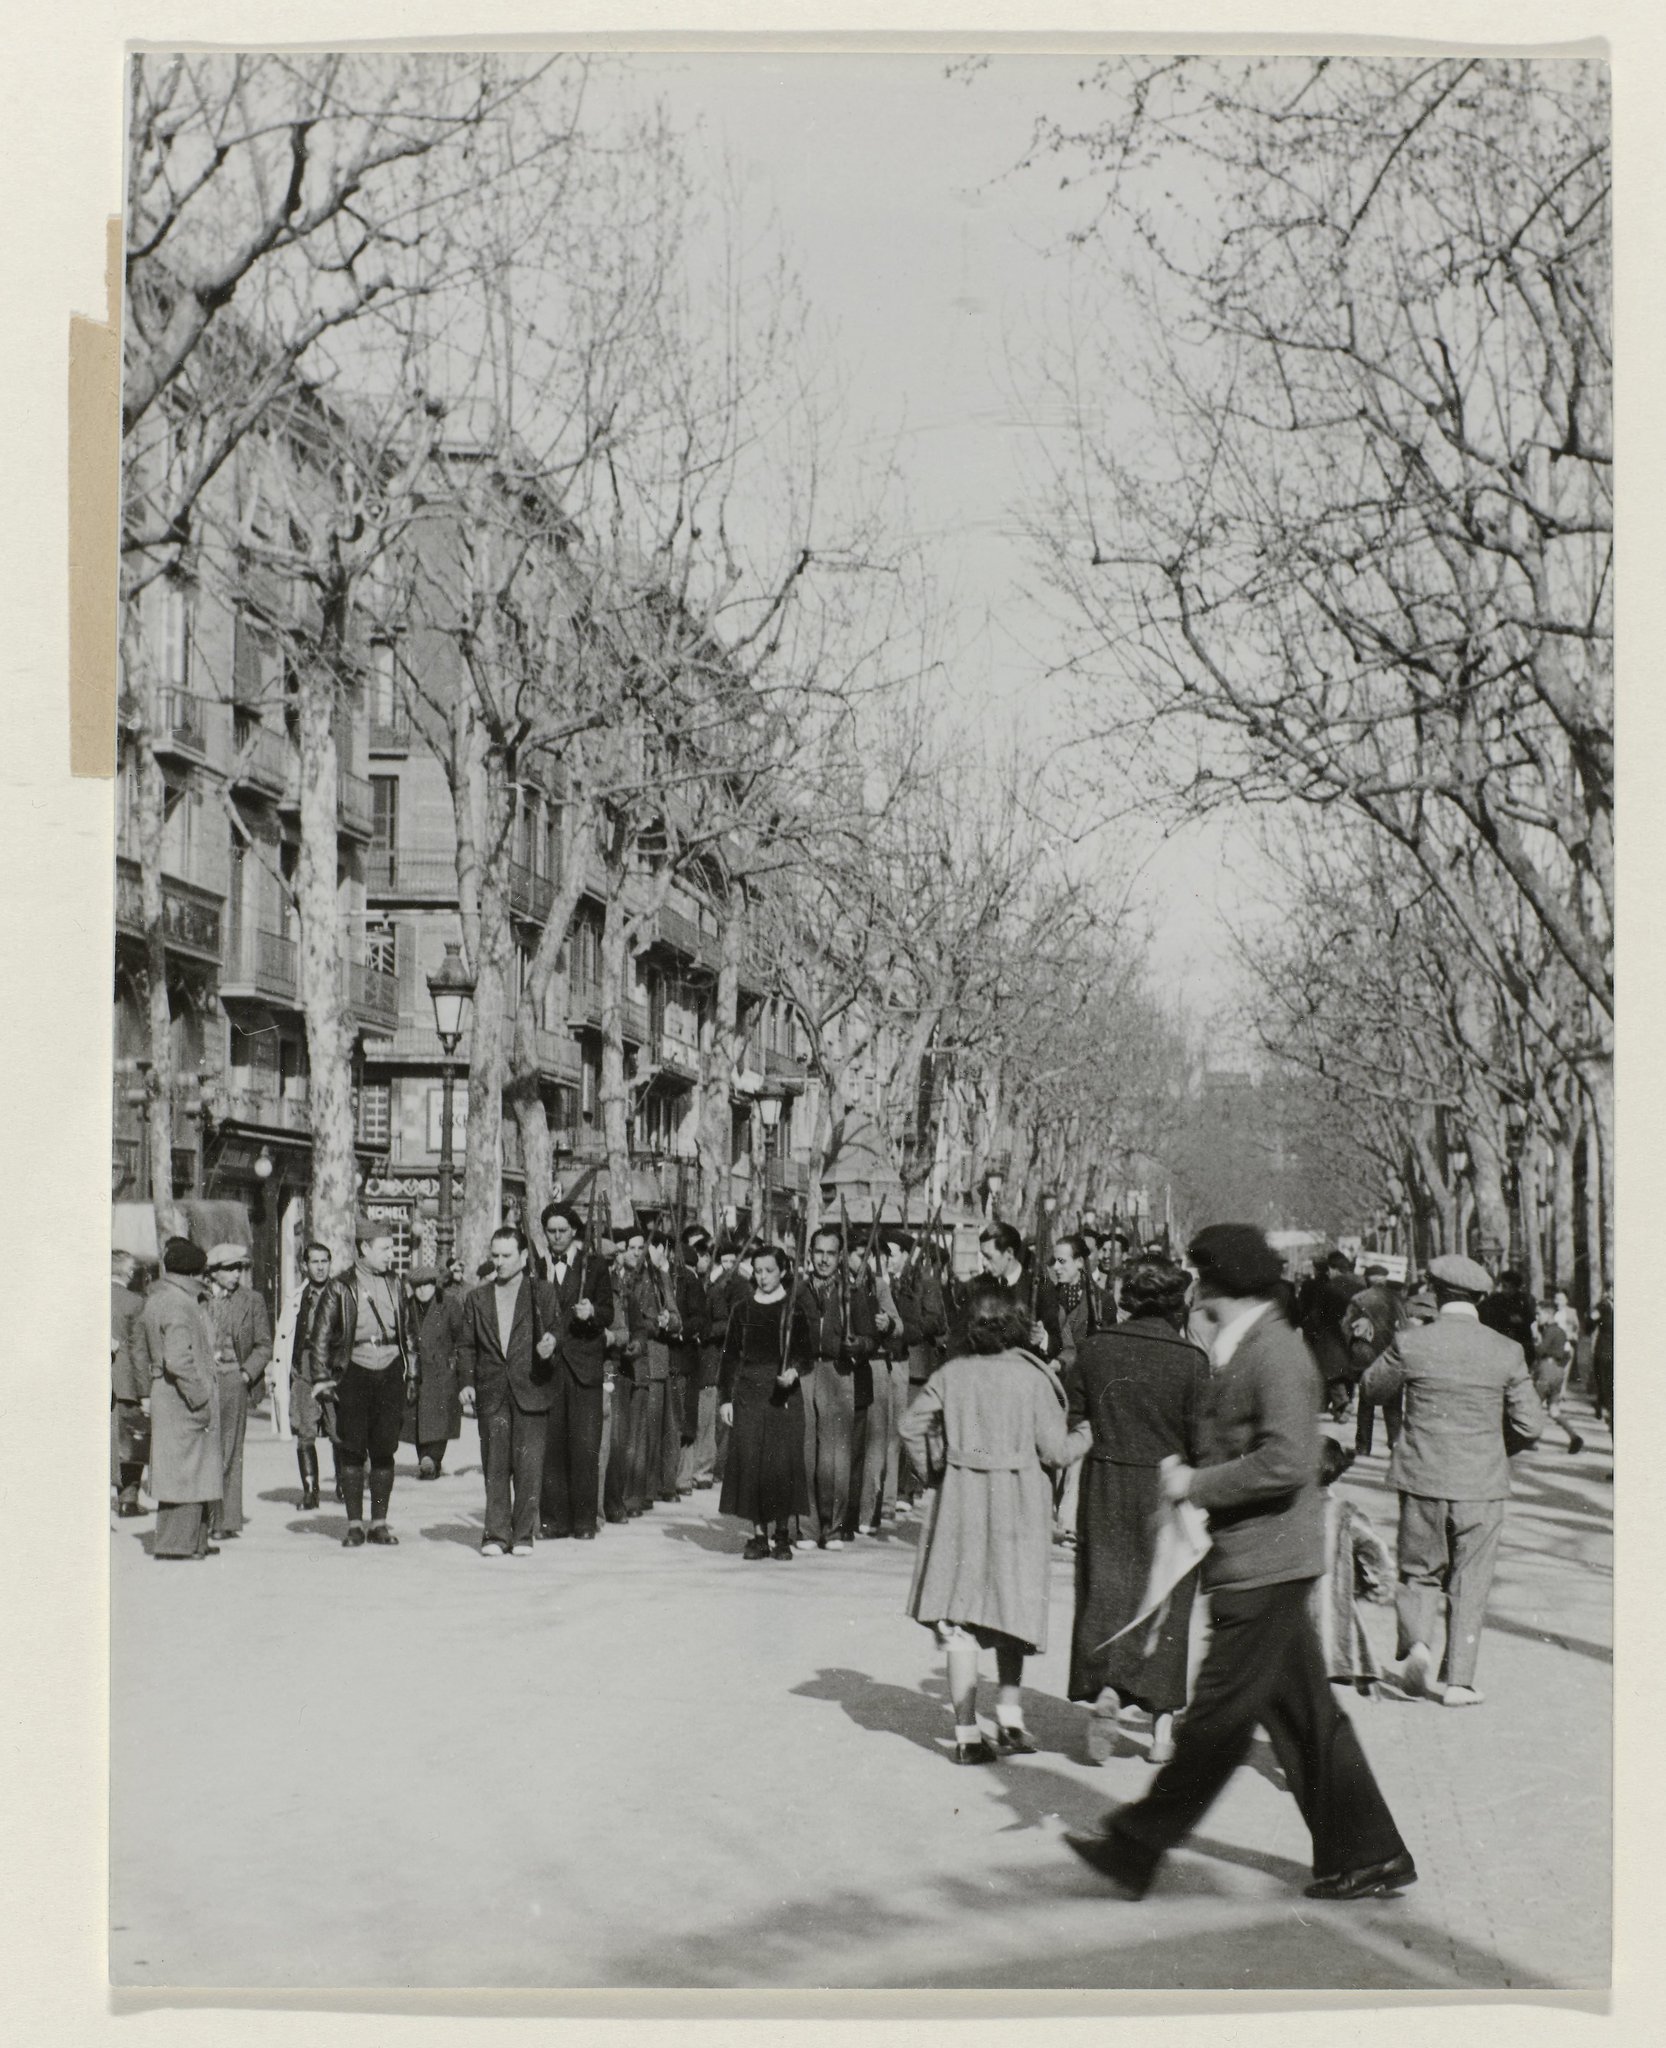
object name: news photograph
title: Red Spain mobilizes her reserves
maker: Anonymous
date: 1937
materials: photographic support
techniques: gelatin silver print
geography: amsterdam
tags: barcelona, spaanse burgeroorlog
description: Gewapende republikeinse burgers oefenen met wapens in de straten van Barcelona, 28 april 1937, tijdens de Spaanse Burgeroorlog. Op de achterzijde twee stempels en blaadje met perstekst in het Engels.